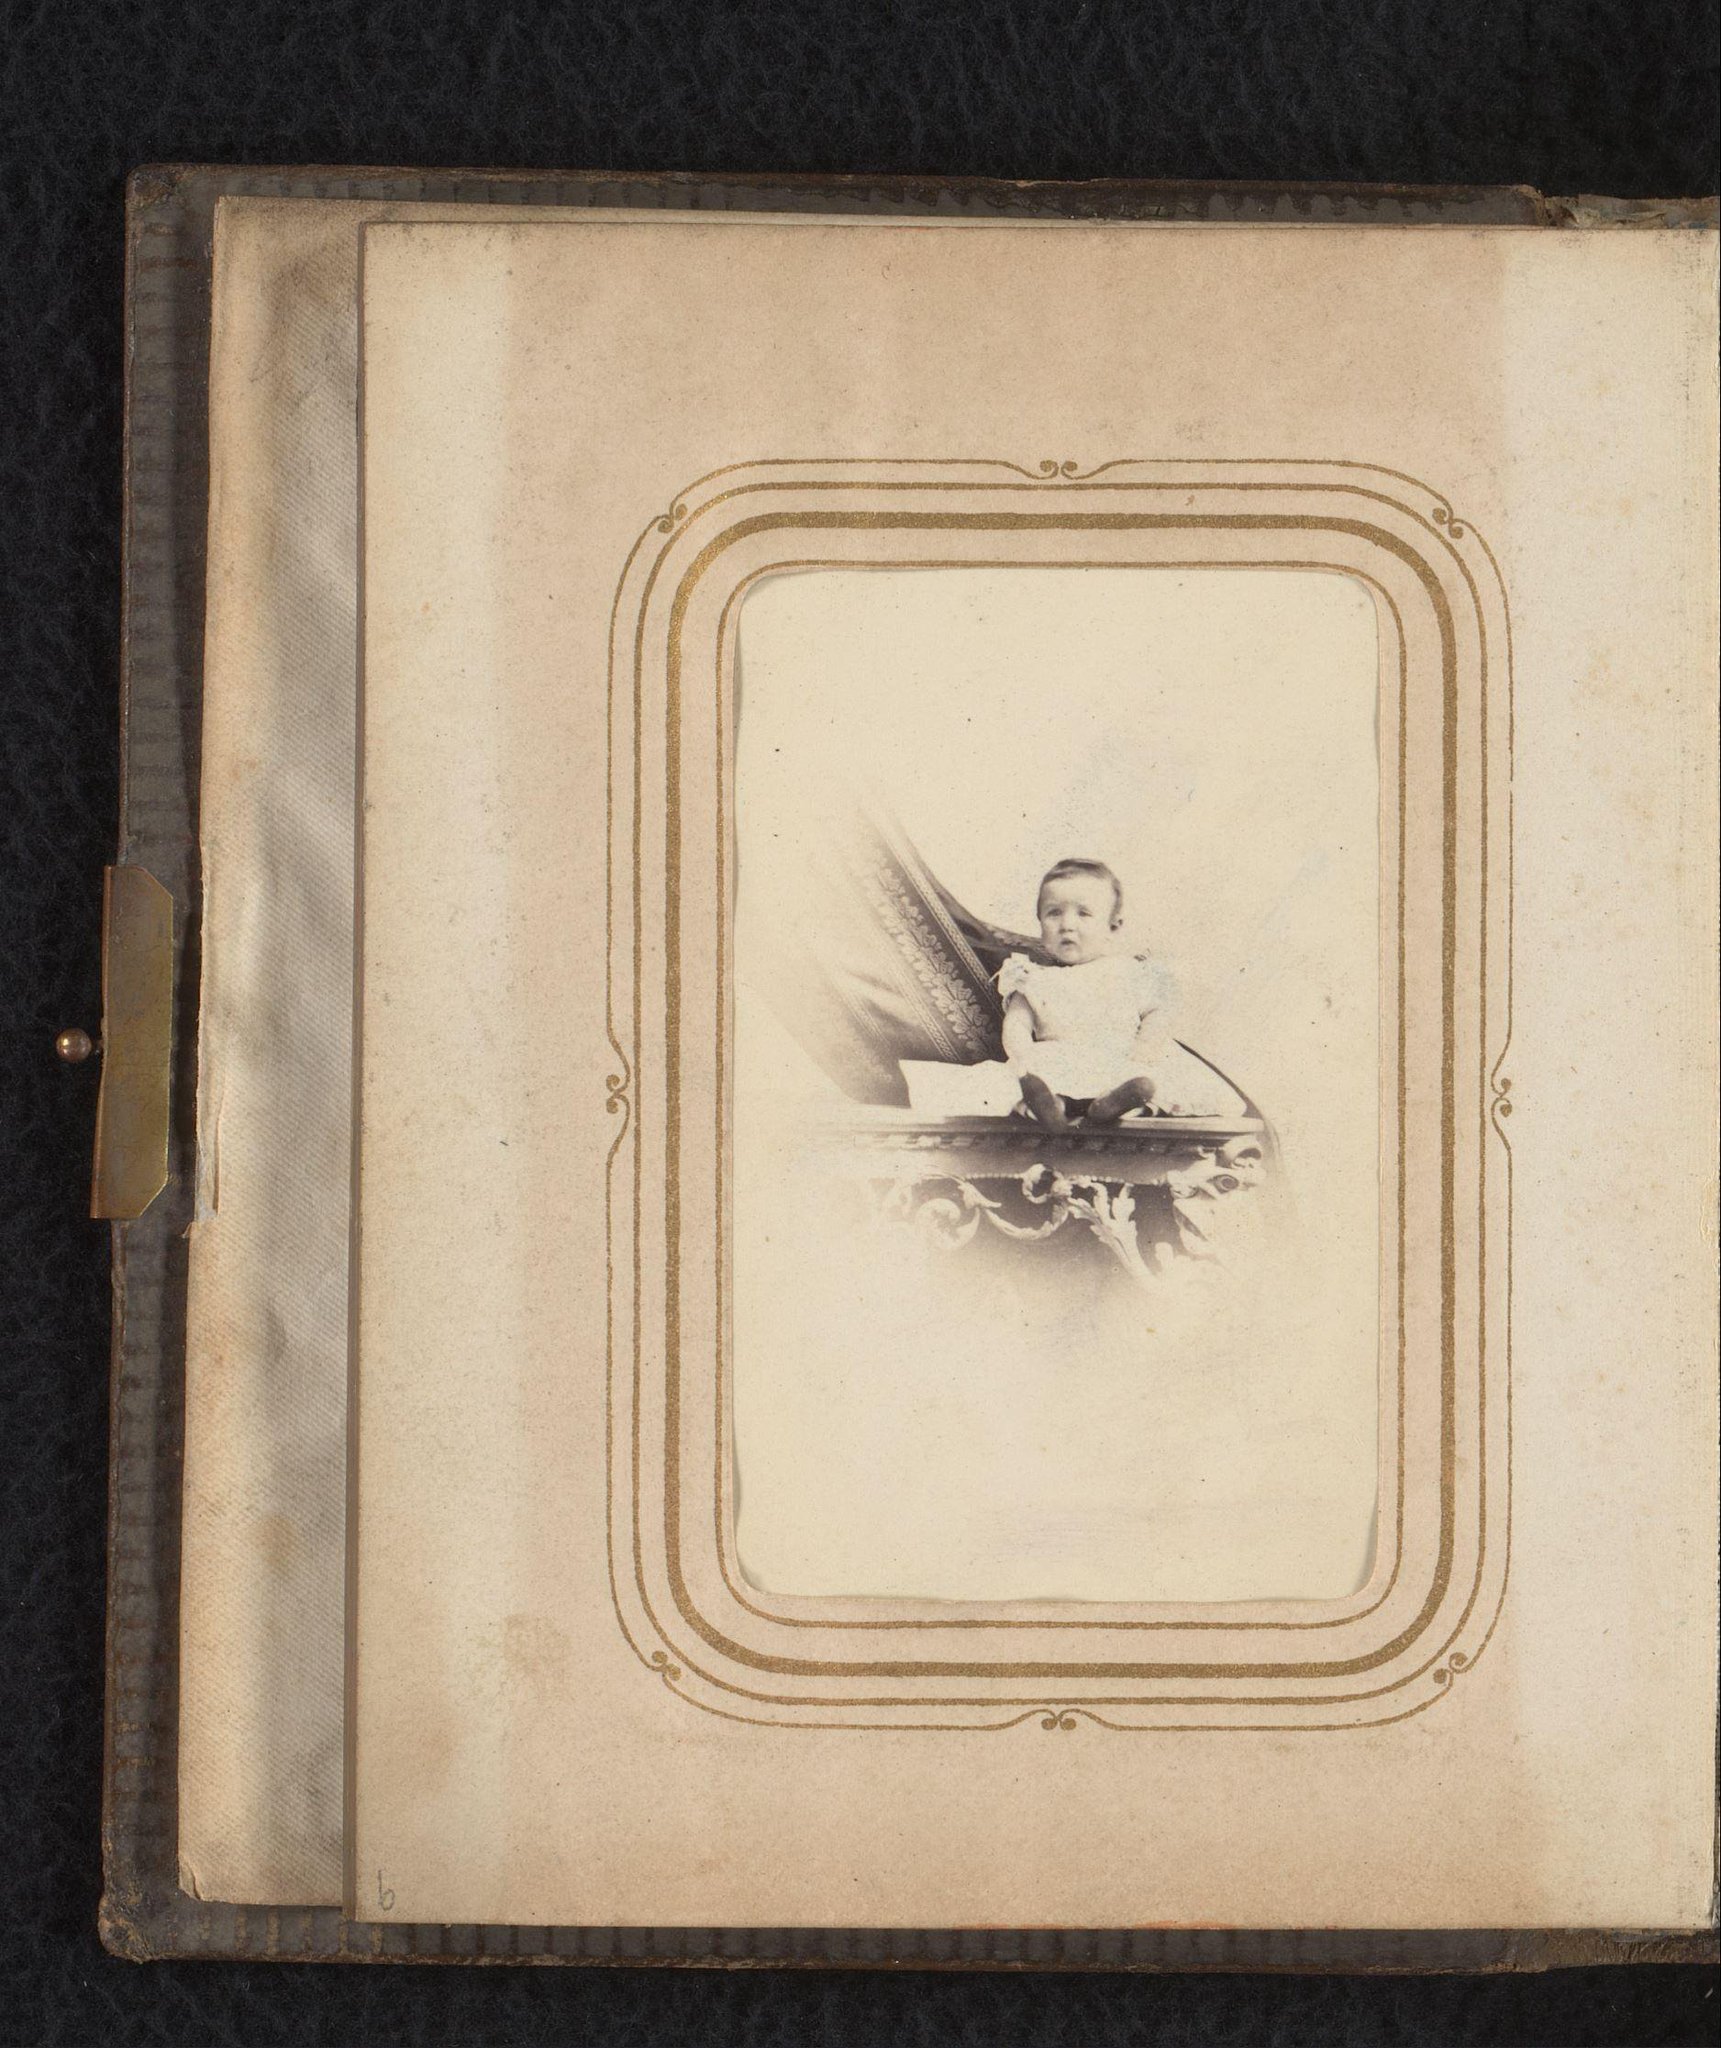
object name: carte de visite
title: Portret van een zittende baby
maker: john eastman palmer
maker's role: fotograaf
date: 1865-1900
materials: cardboard, photographic support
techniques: albumen print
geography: devon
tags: infant, baby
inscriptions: inscription: ‘Photographed by/ John E. Palmer/ 58, Union Street, Stonehouse/ Devon’